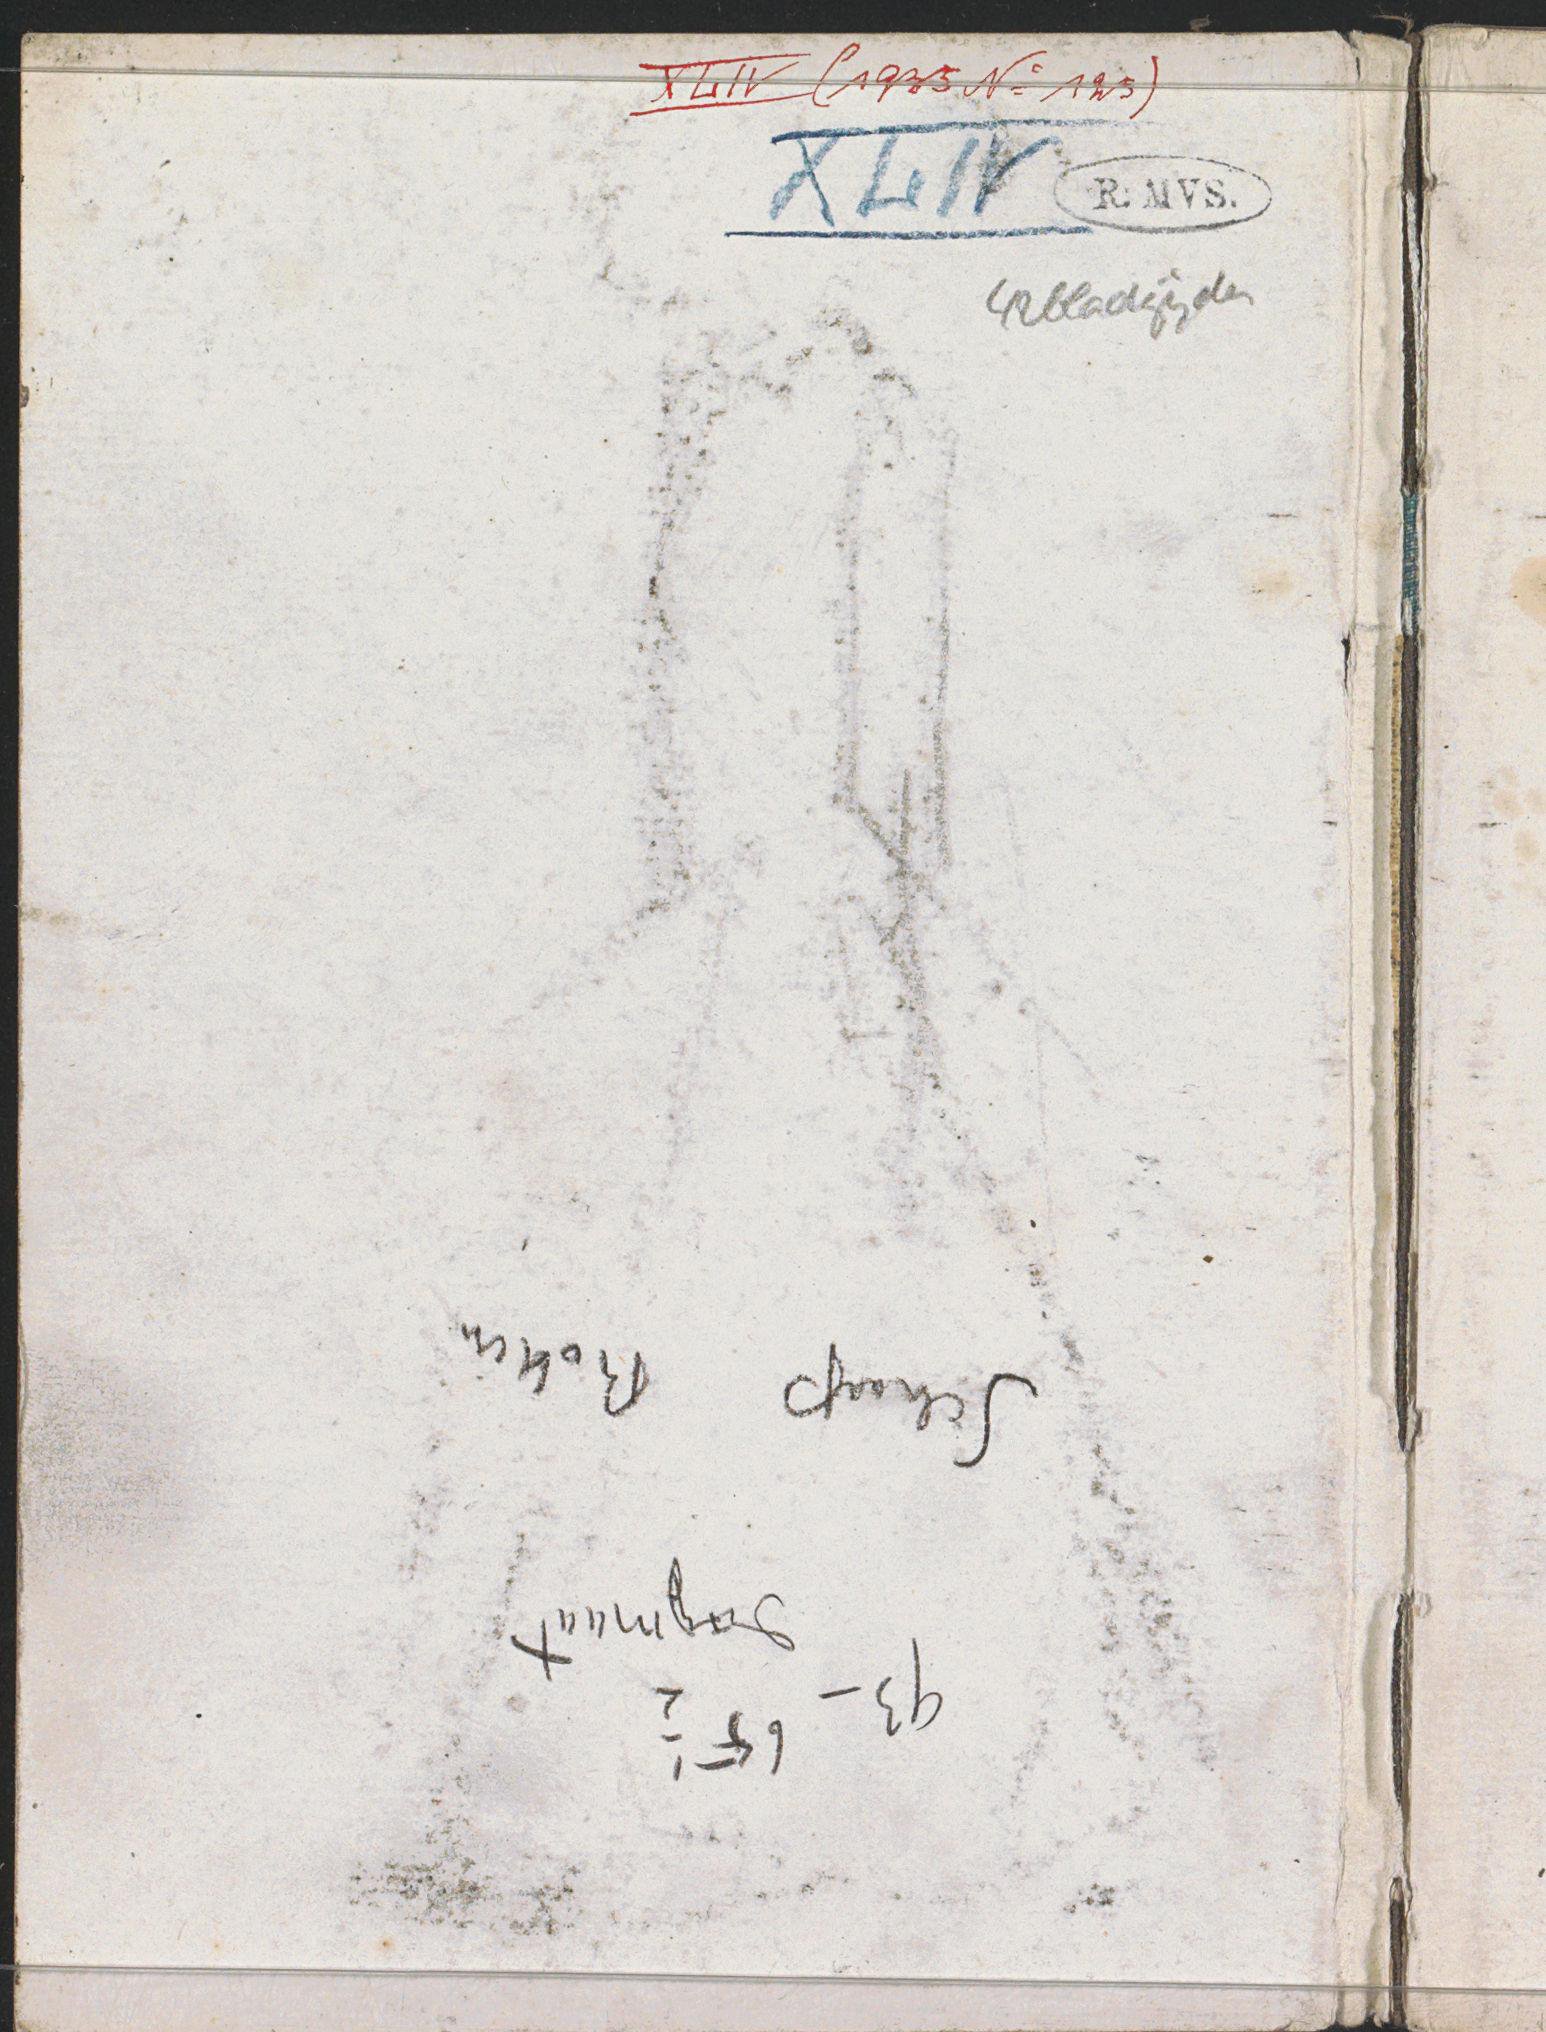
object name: sketchbook leaf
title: Annotaties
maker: isaac israels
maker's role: draughtsman, painter, print maker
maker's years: 1865-1934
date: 1875-1934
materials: chalk, paper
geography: the hague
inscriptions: collector's mark: Lugt 2228, annotation: ‘93_ 65 1/2 / dagmaat / Schaap Rokin’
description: Pagina 1, voorste schutblad, uit schetsboek XLIV met 43 pagina's.